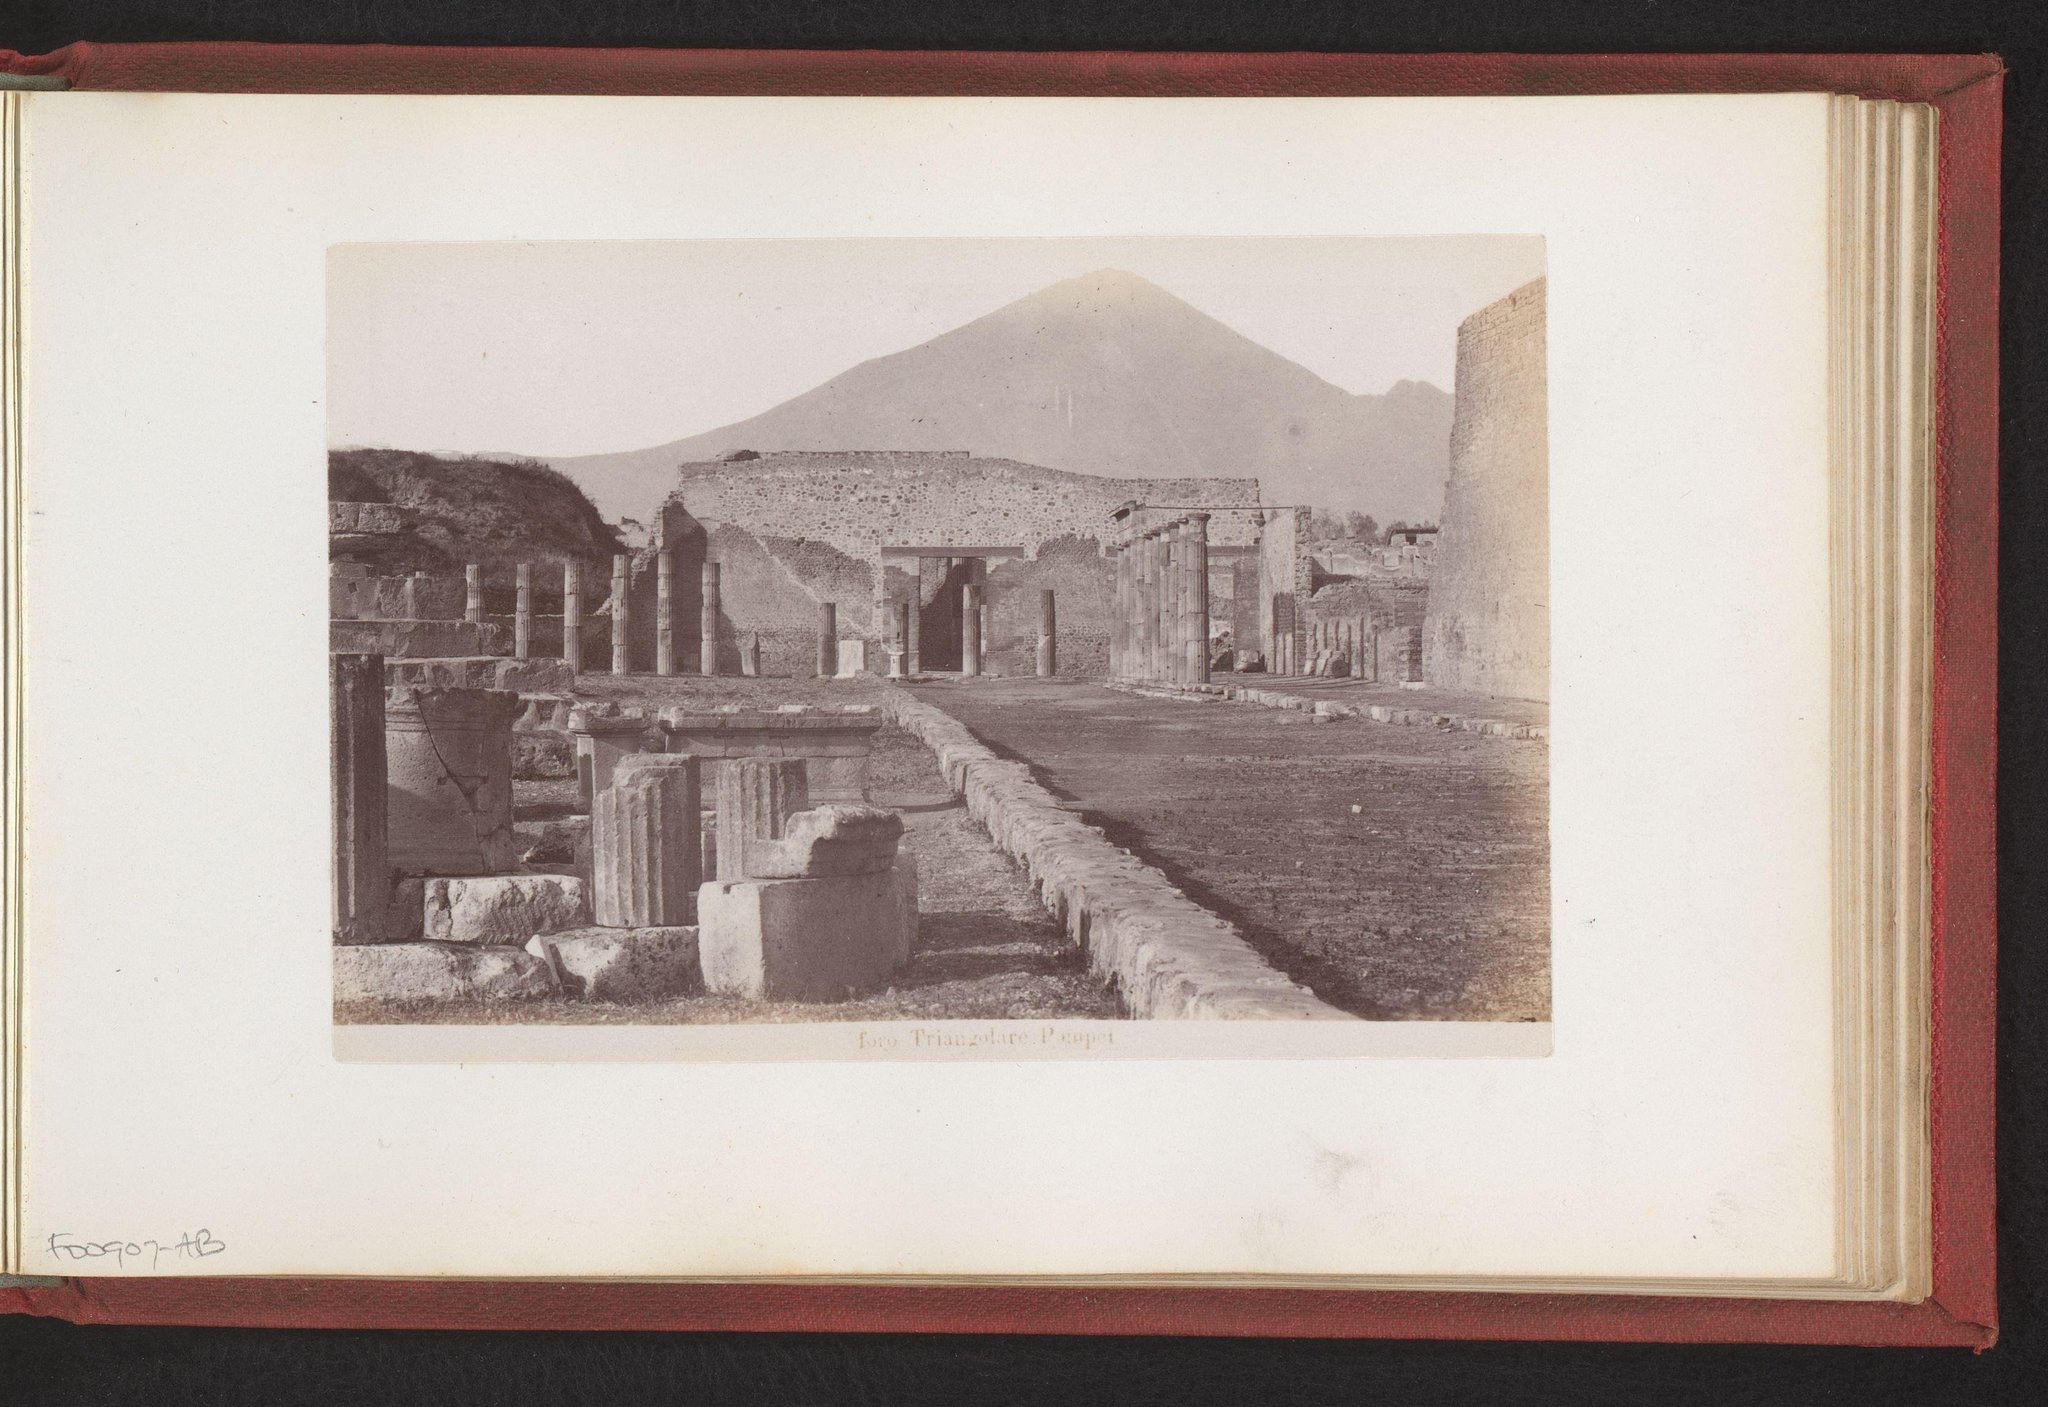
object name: photograph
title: Foro Triangolare Pompei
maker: Anonymous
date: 1860-1900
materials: photographic support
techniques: albumen print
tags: ruin of a building ~ architecture, village square, place